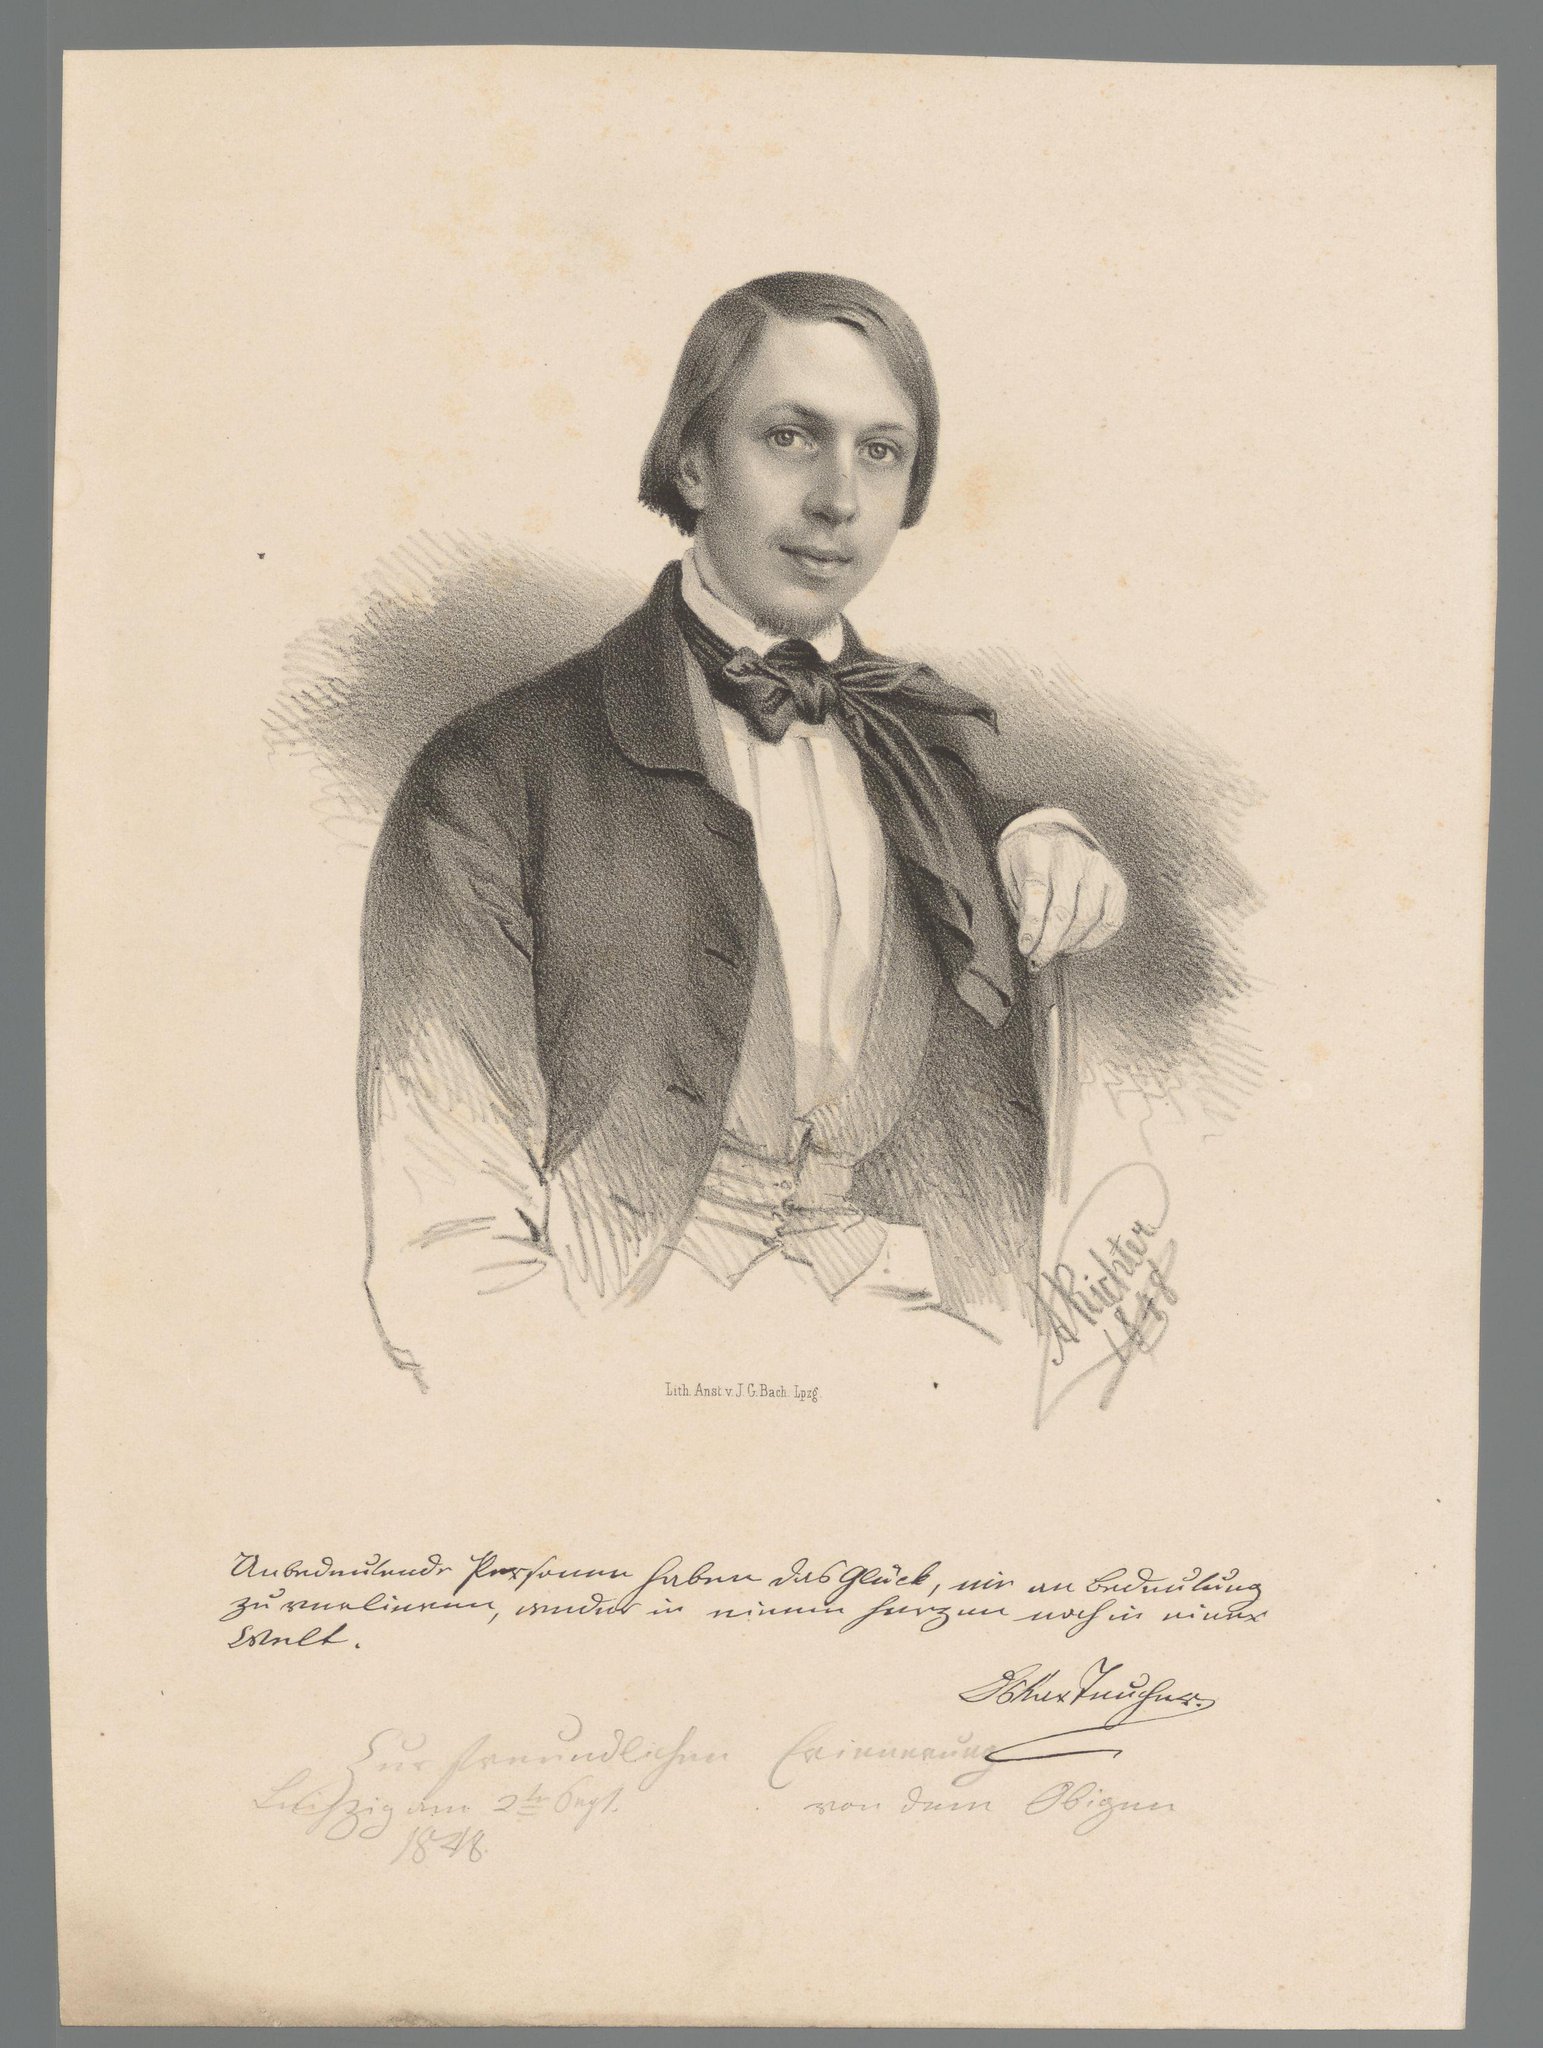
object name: print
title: Portret van Tuncher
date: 1848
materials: paper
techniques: lithograph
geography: leipzig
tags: historical persons not known by name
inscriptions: collector's mark: Lugt 2228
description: Portret van een verder onbekende man met de naam Tuncher.